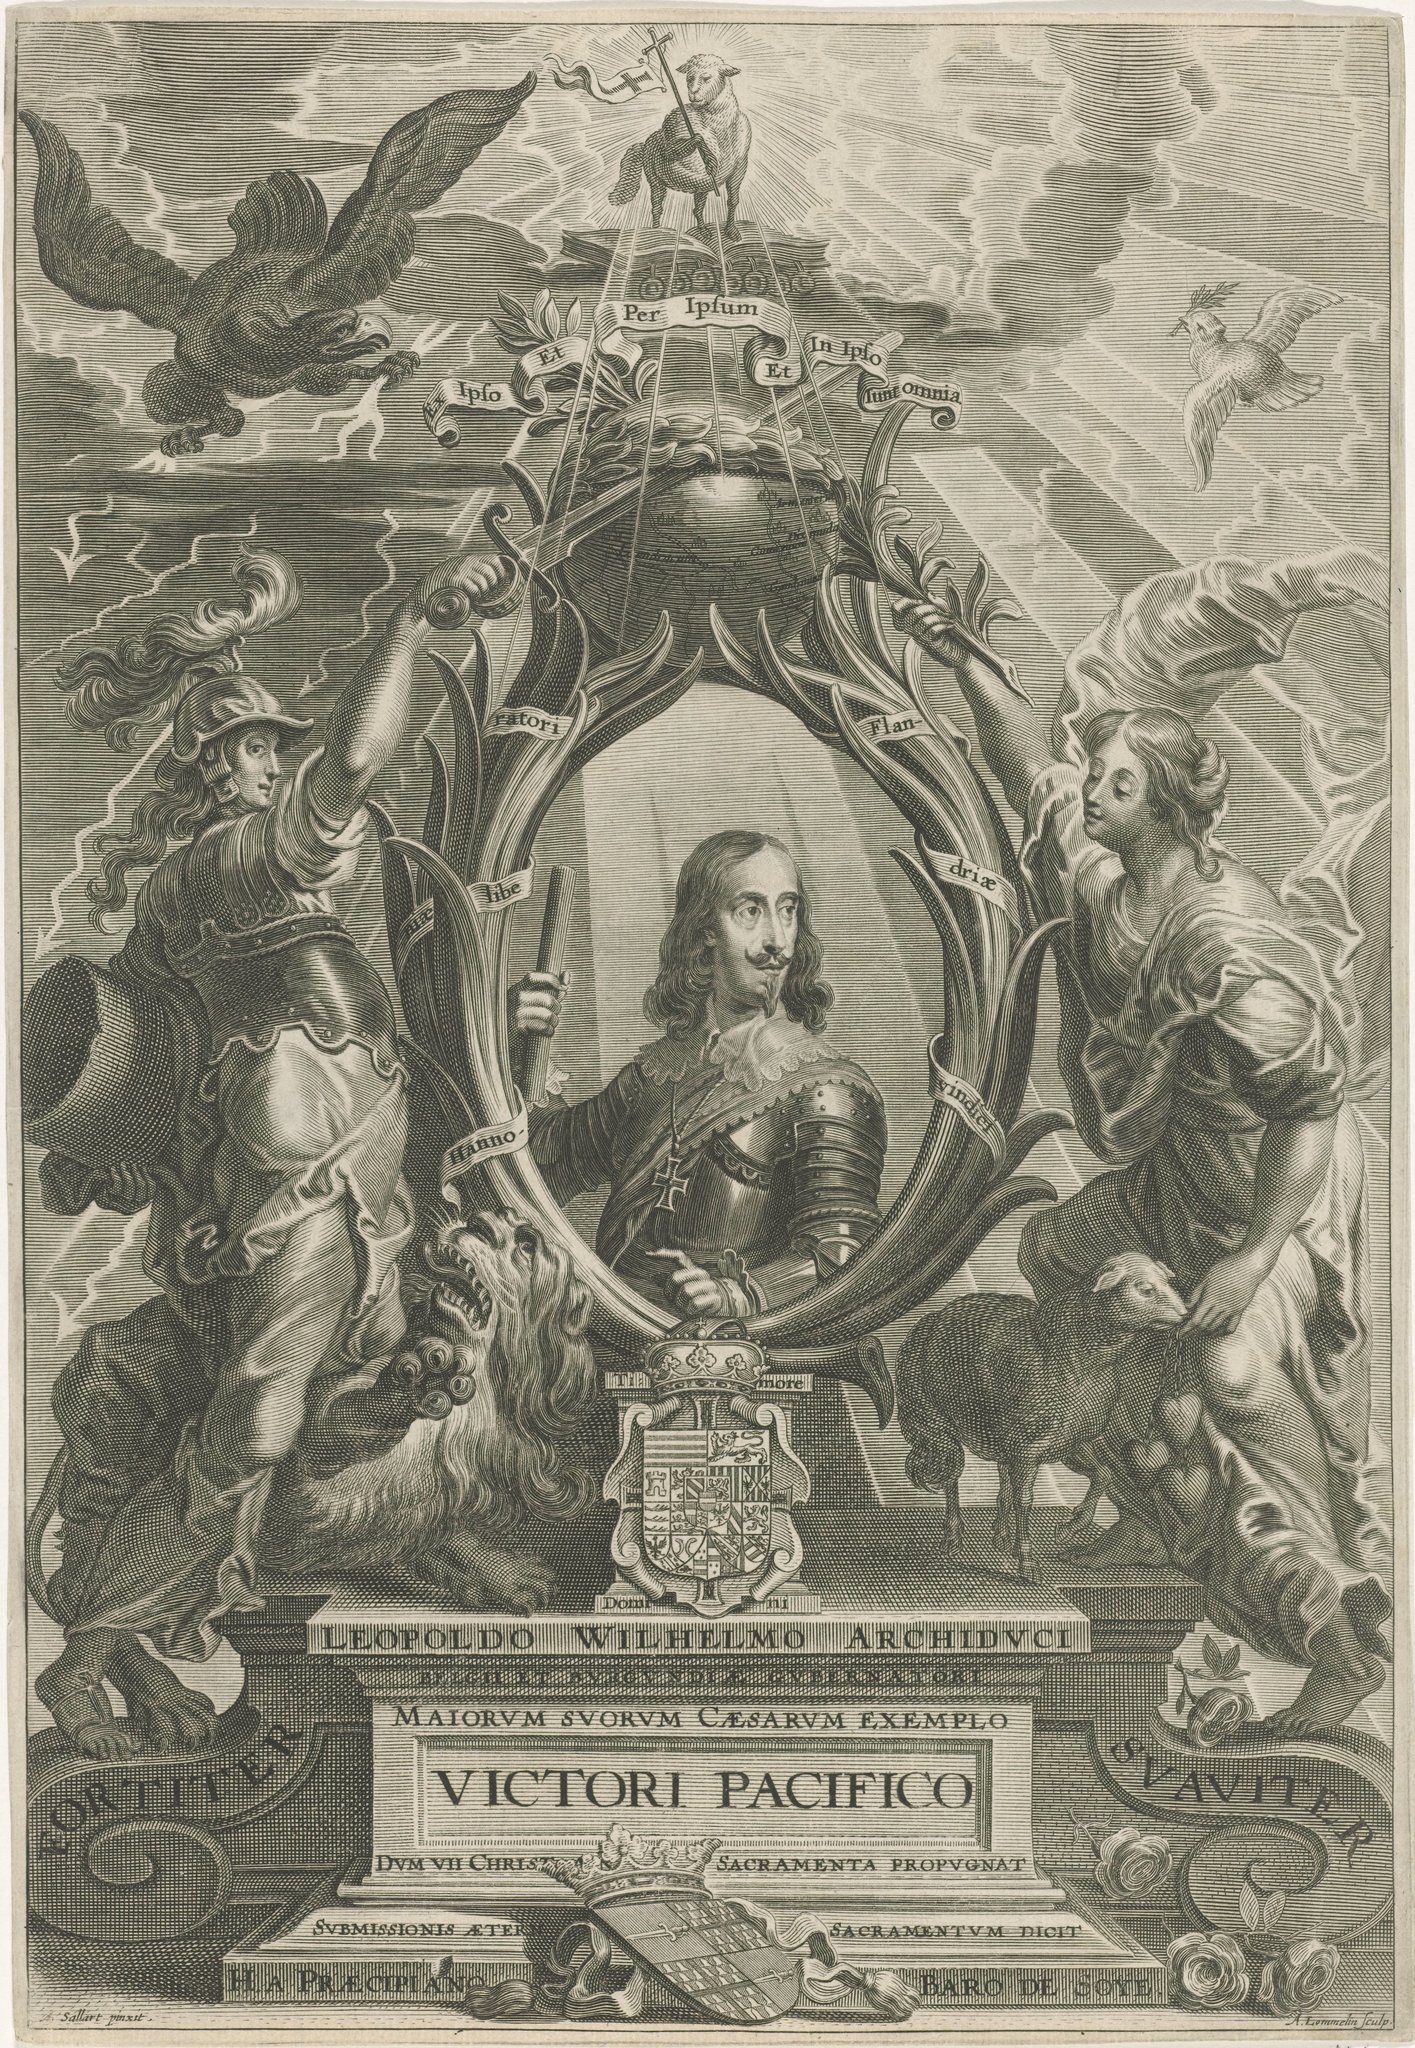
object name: print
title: Portret van Leopold Willem, aartshertog van Oostenrijk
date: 1630-1677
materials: paper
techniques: engraving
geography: antwerp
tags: vienna, leopold willem van oostenrijk (landvoogd der zuidelijke nederlanden), meekness; 'mansuetudine' (ripa), fortitude, 'fortitudo' ~ one of the four cardinal virtues, lamb bearing cross or banner, 'agnus dei' ~ symbol of christ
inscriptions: collector's mark: Lugt 2228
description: Portret van Leopold Willem, aartshertog van Oostenrijk, landvoogd der Spaanse Nederlanden. Het portret wordt geflankeerd door de gepersonifieerde Kracht (links) en Zachtmoedigheid (rechts). Onder het portret het gekroonde wapenschild van de geportretteerde. Boven in de lucht is het Lam Gods verschenen.